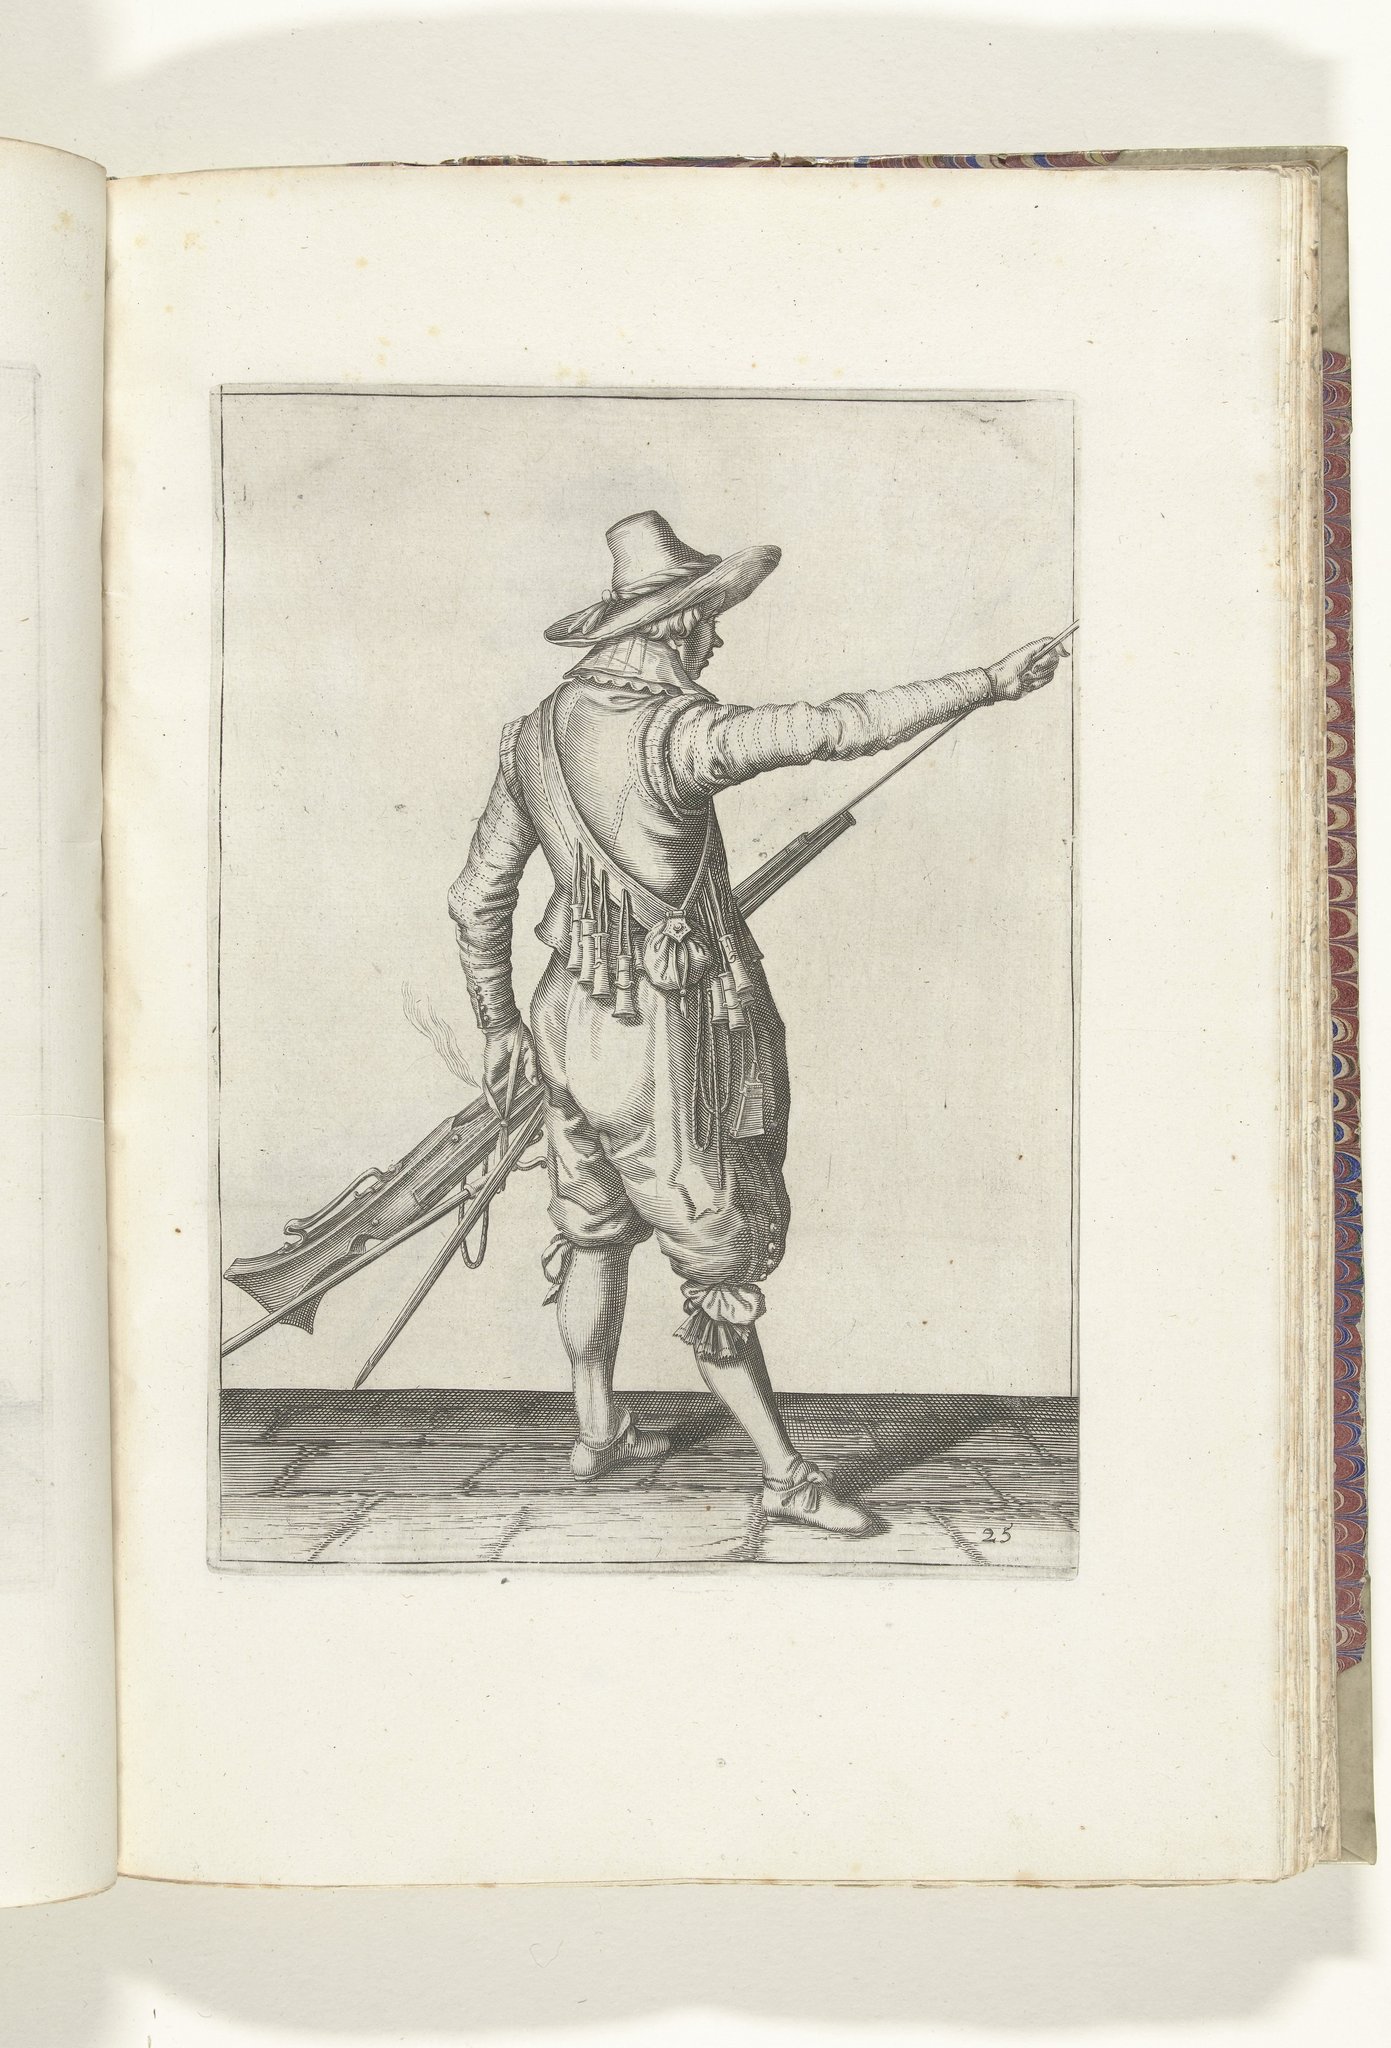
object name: print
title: Soldaat die zijn laadstok uit de houder onder de loop van zijn musket haalt (nr. 25), ca. 1600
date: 1597-1607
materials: paper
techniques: engraving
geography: northern netherlands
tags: maurice (prince of orange), handling of weapons ~ military training, weapons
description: Een soldaat, ten voeten uit, naar rechts, op de rug gezien, die met zijn linkerhand bij zijn linkerdijbeen een musket (een bepaald type vuurwapen) vasthoudt en met zijn rechterhand de laadstok uit de houder onder de loop haalt (nr. 25), ca. 1600. In zijn linkerhand behalve het musket ook een brandende lont; aan zijn linkerpols een furket (musketvork). Plaat 25 in de instructies voor het hanteren van het musket: Corte onderrechtinghe op de figuerlicke afbeeldinghe, soo veel aengaet het recht ghebruyck van Musquet. Onderdeel van de illustraties in: J. de Gheyn, Wapenhandelinghe van Roers Musquetten ende spiessen, Amsterdam, 1608. Krijgswezen rond 1600.